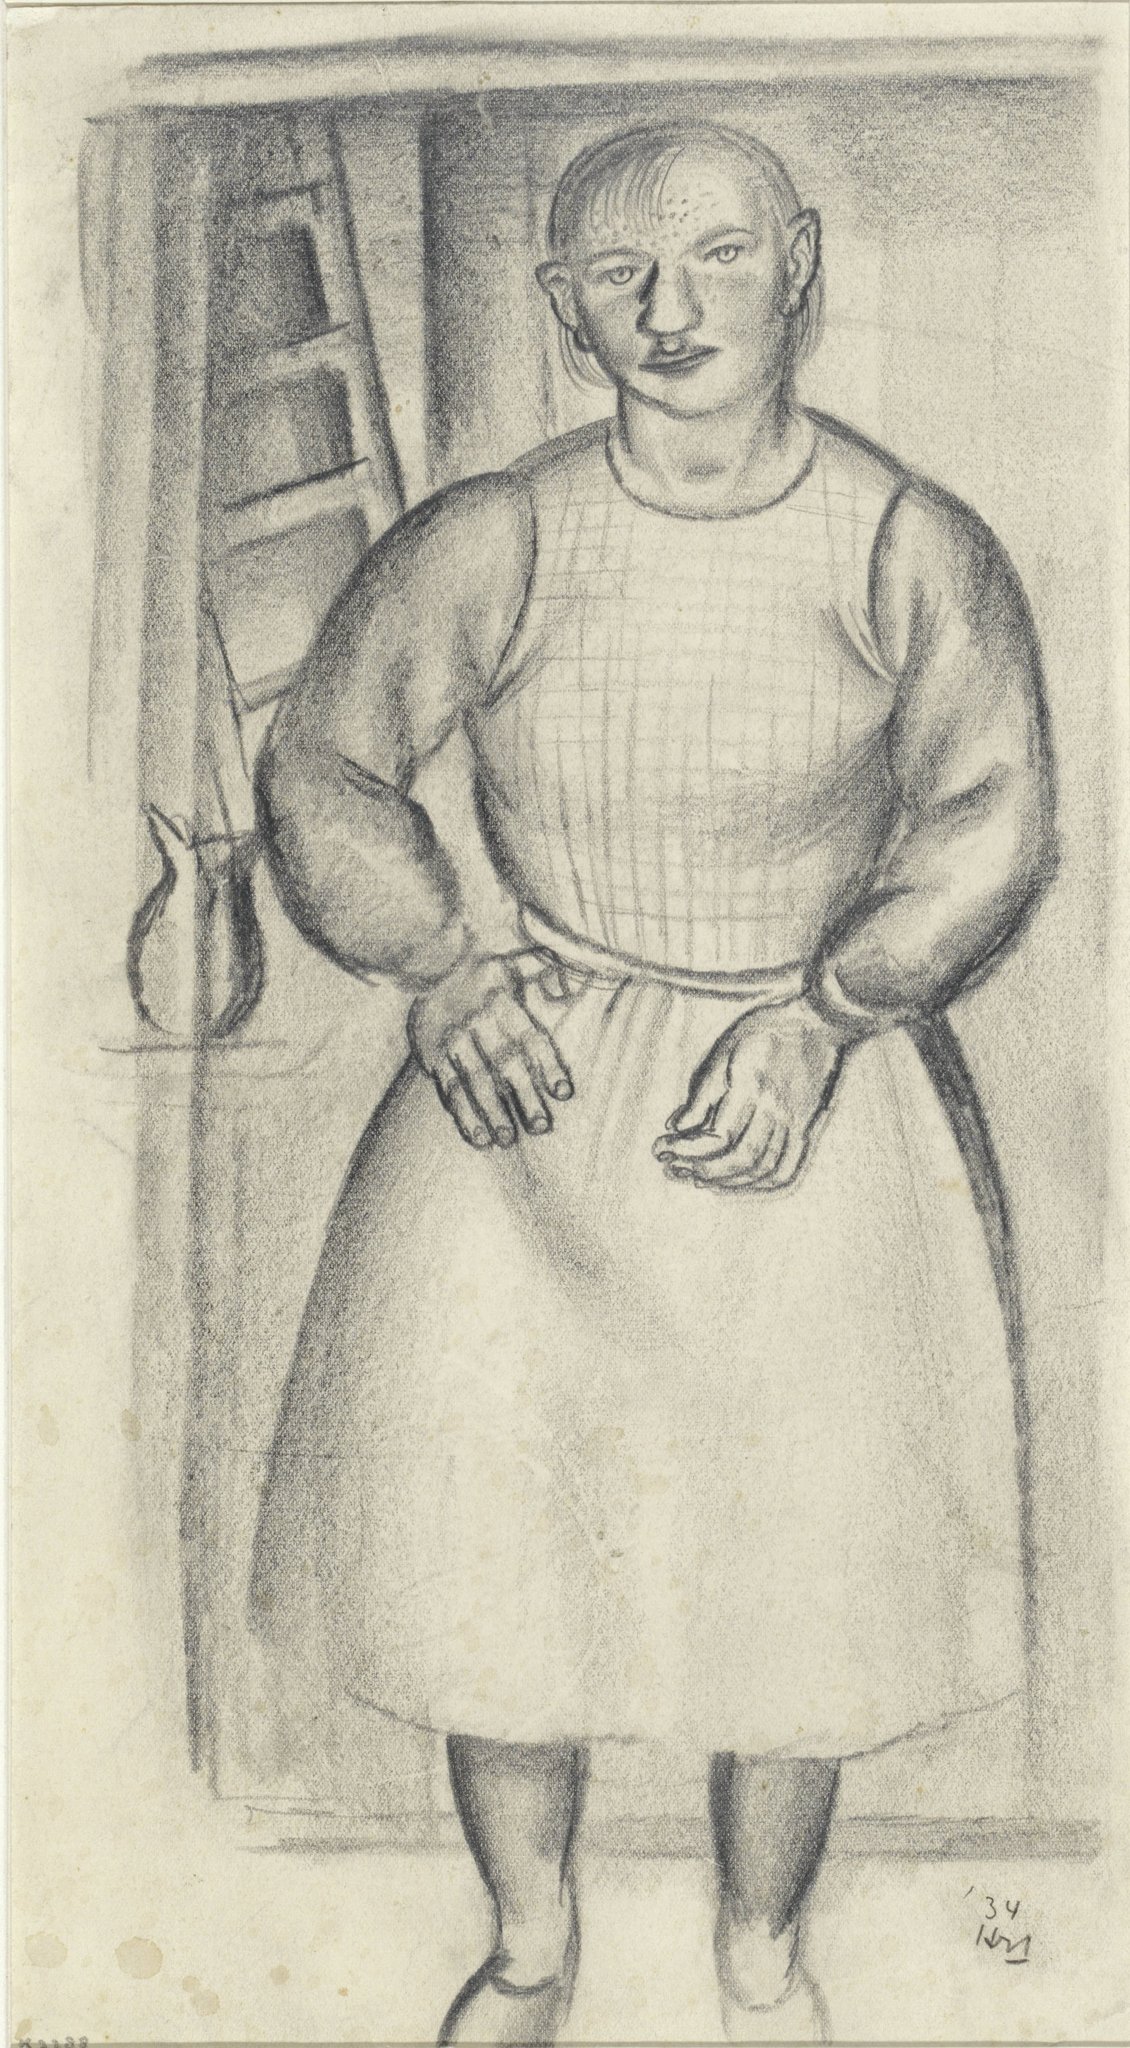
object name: drawing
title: Staande vrouw met schort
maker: henk henriët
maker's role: draughtsman, print maker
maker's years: 1903-1945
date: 1934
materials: paper, pencil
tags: standing figure - aa - female human figure, ladder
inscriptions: workshop stamp: ‘No. 52 atelier H. Henriët [7.7.]H.’, collector's mark: Lugt 2228, inscription: ‘K2288’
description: Staande vrouw in een kamer met haar rechterhand in haar zij. Naast haar staat een vaas op een plank en achter de vrouw staat een ladder.